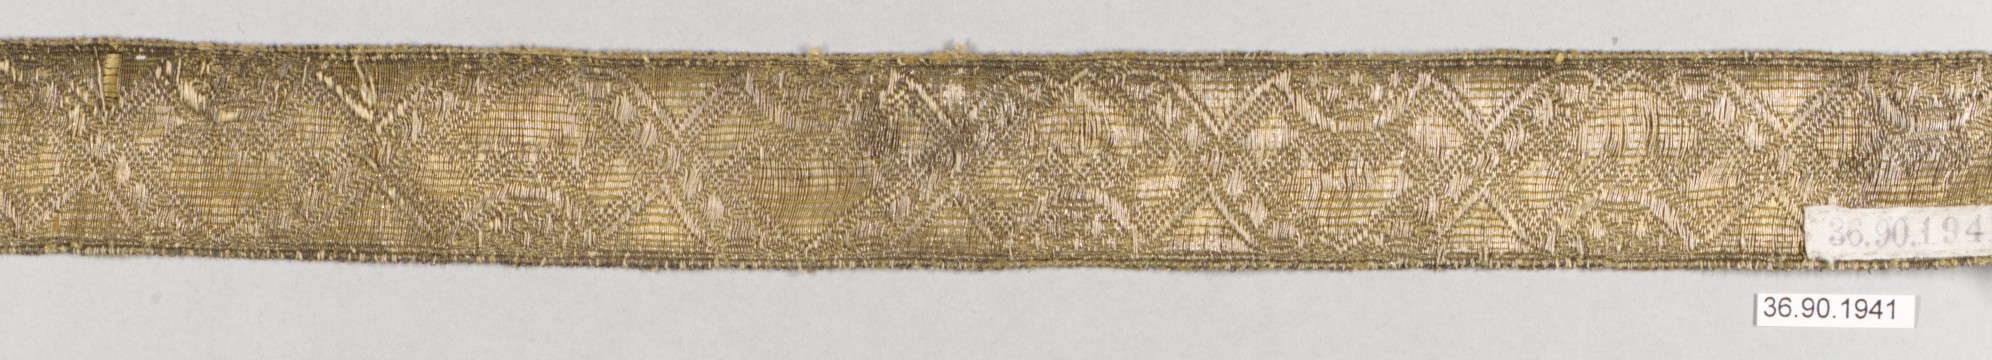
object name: galloon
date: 1801-1900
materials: metal thread, silk